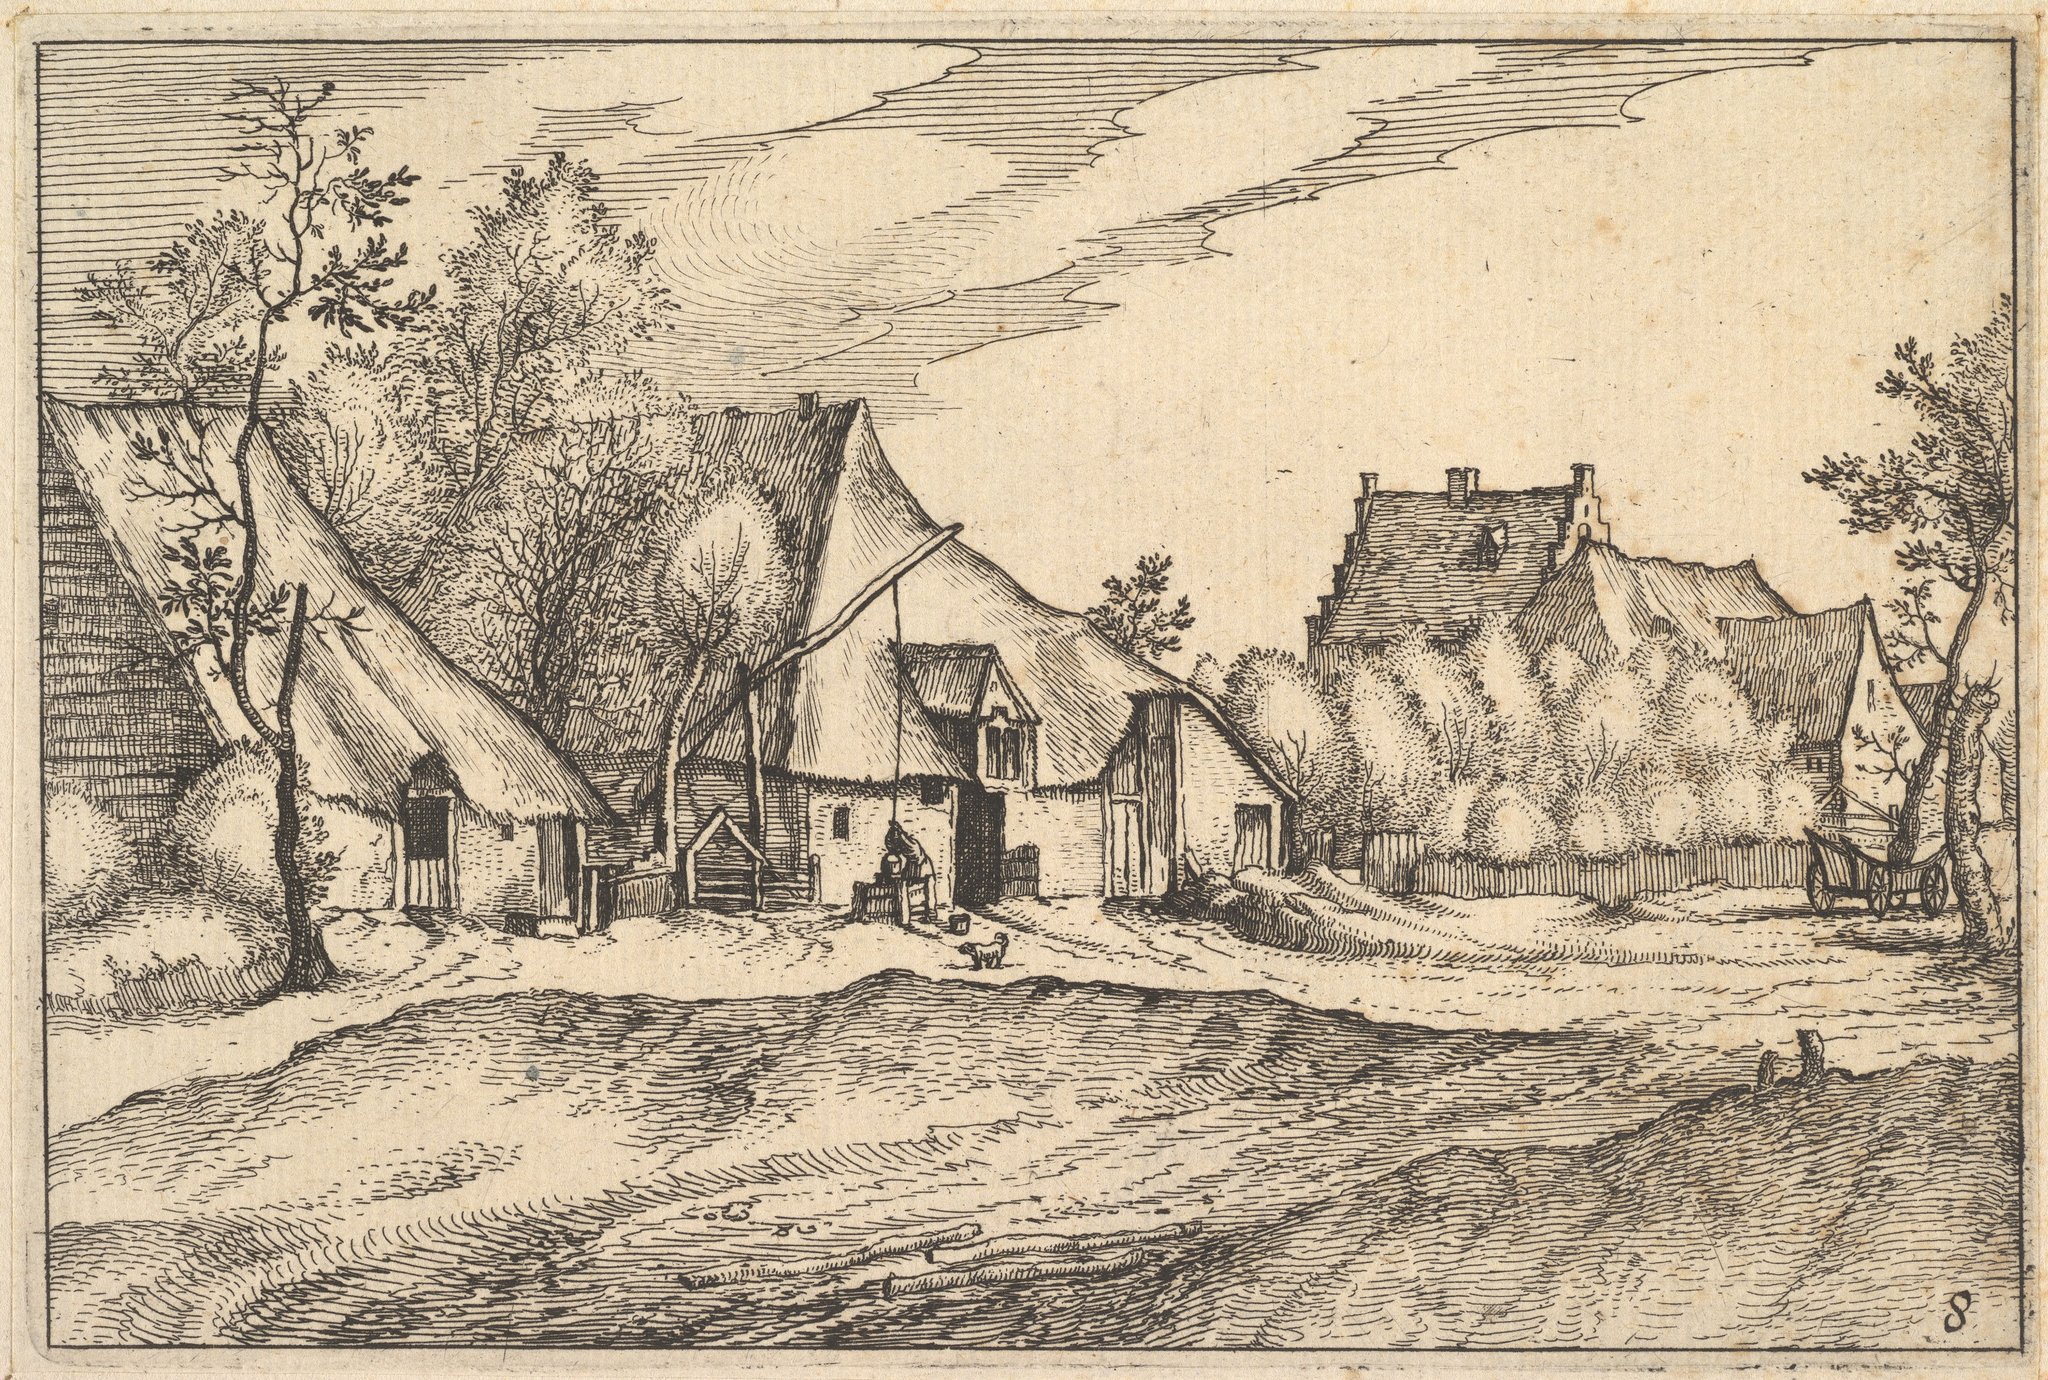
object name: print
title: Farms in a Village, from "Regiunculae et Villae Aliquot Ducatus Brabantiae"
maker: claes jansz. visscher (ii)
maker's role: artist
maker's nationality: dutch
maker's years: 1586-1652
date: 1610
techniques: etching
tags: farms,villages